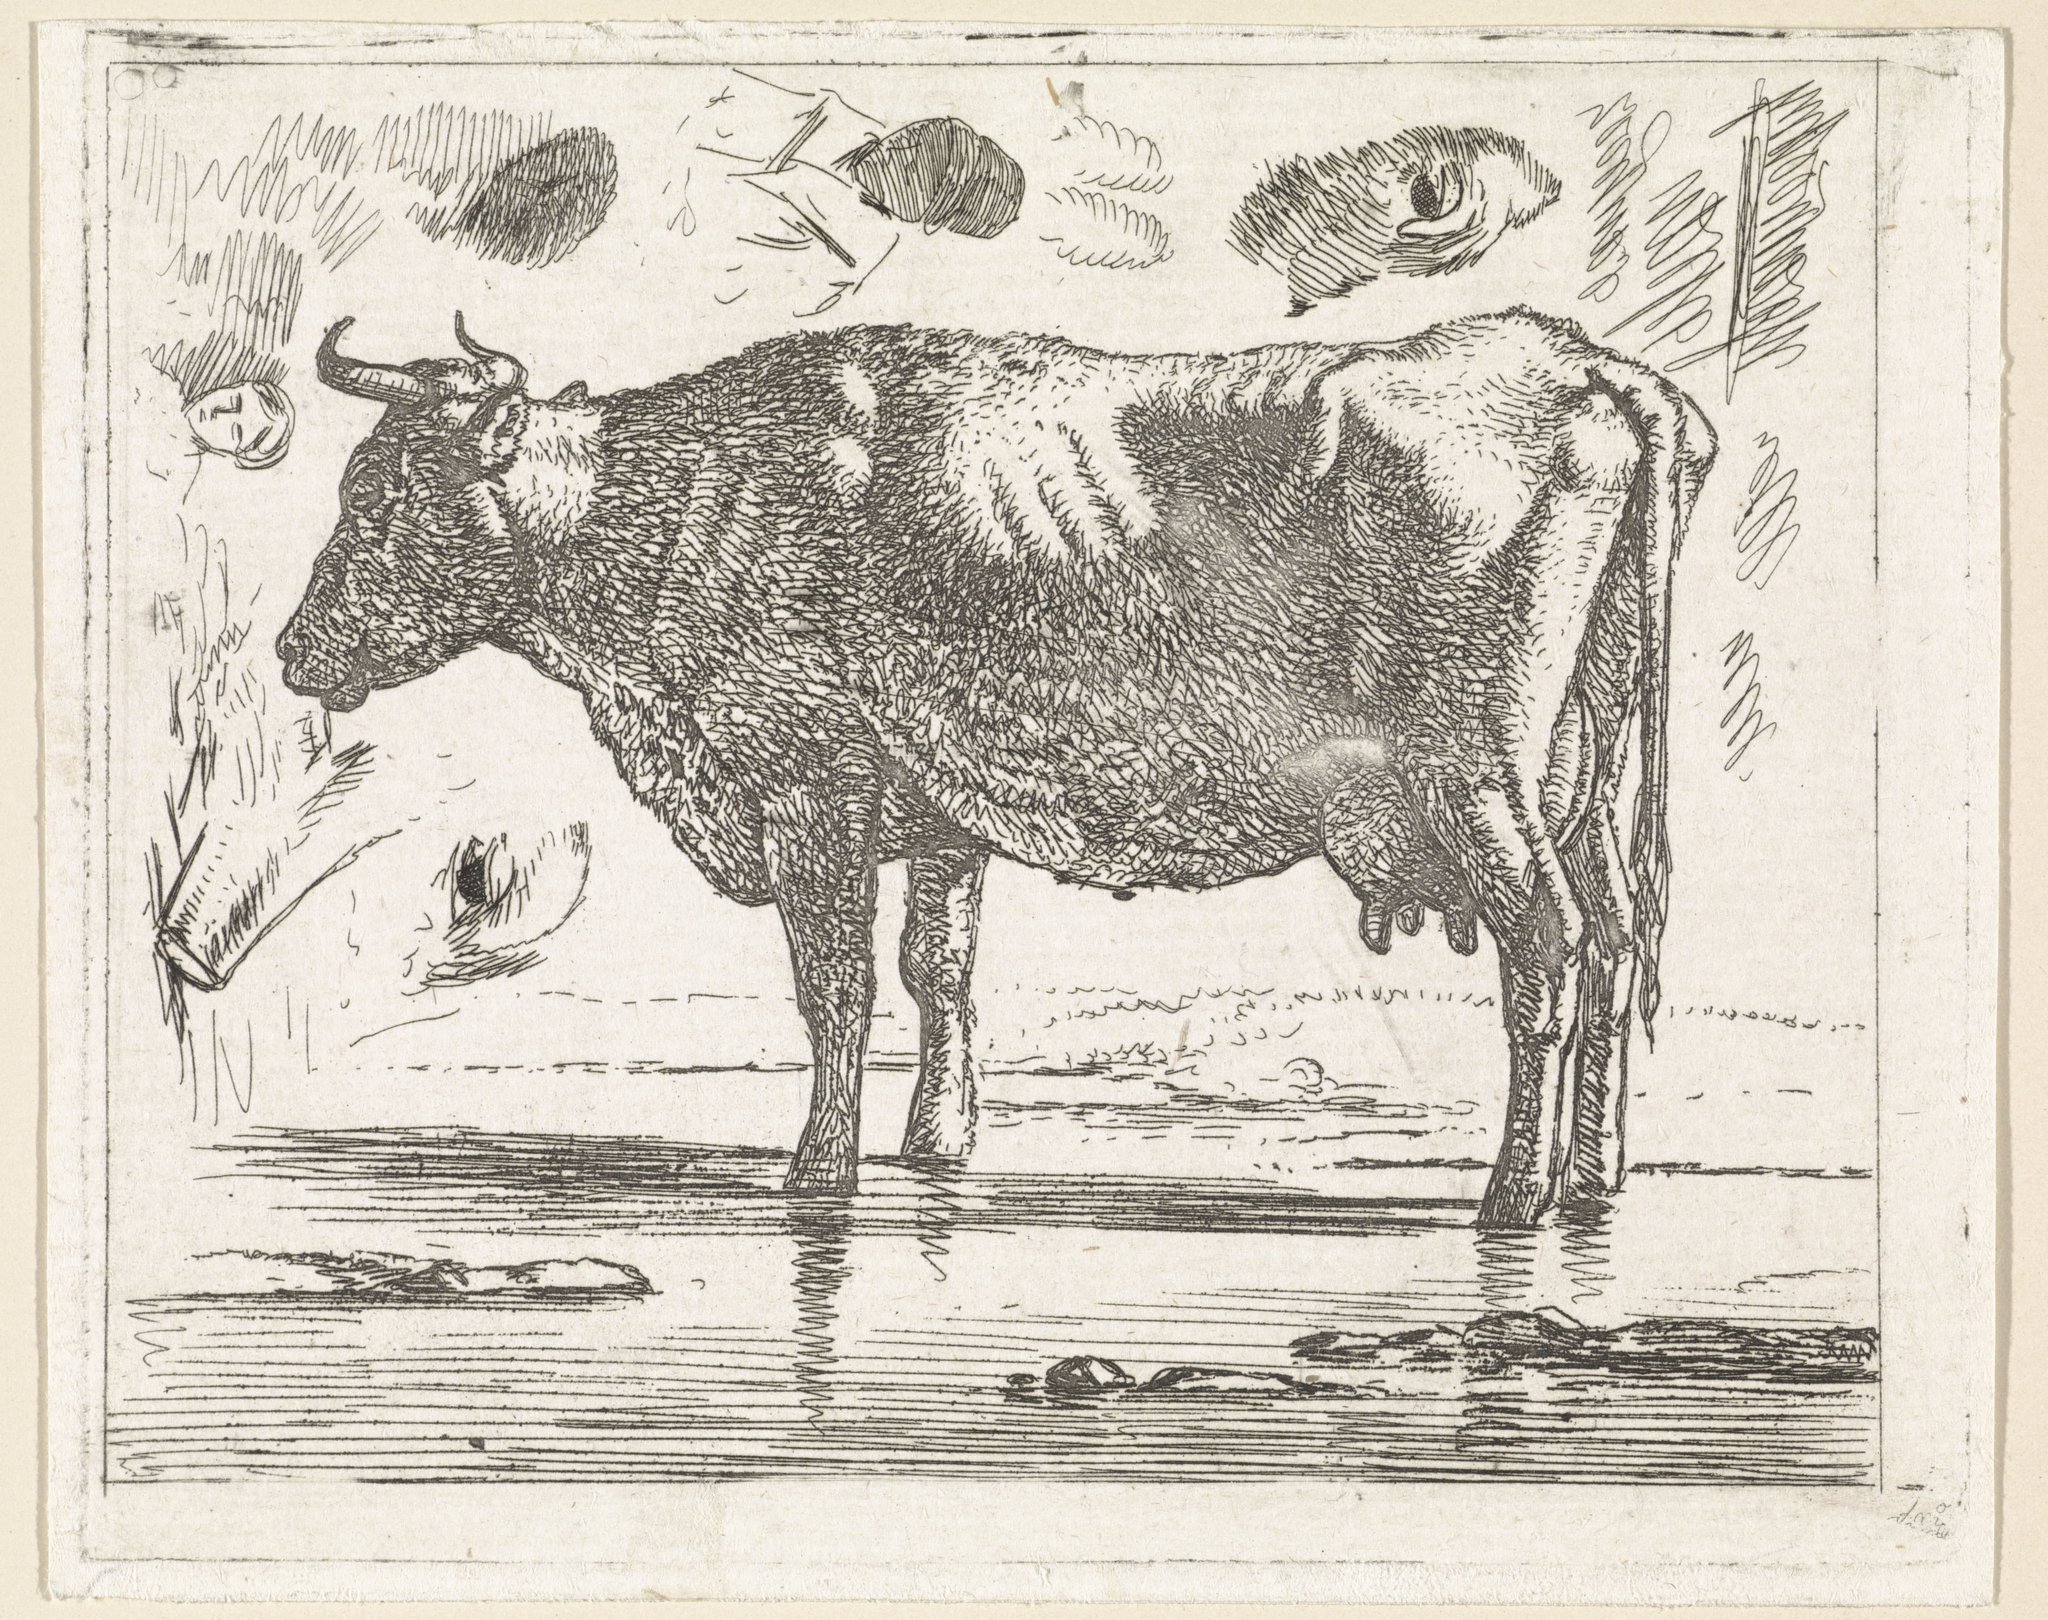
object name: print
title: Staande koe in het water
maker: wouter johannes van troostwijk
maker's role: draughtsman, painter, print maker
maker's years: 1782-1810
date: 1792-1810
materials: paper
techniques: etching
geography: amsterdam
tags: cow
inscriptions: collector's mark: Lugt 2228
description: Staande koe in het water. Rondom etsoefeningen.